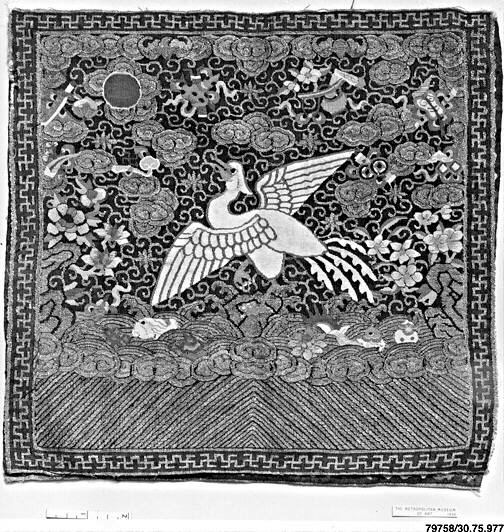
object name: rank badge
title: Rank Badge with Silver Pheasant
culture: chinese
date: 1801-1900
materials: metal thread, silk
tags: pheasants,fish